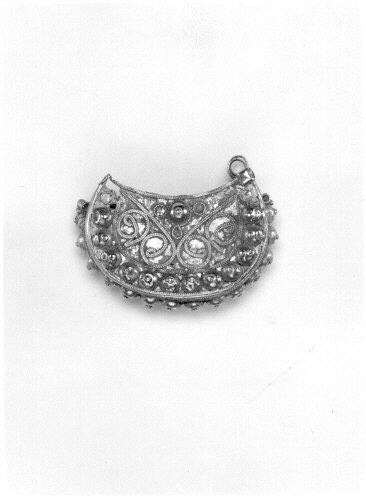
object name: earring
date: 1001-1300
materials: gold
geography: iran